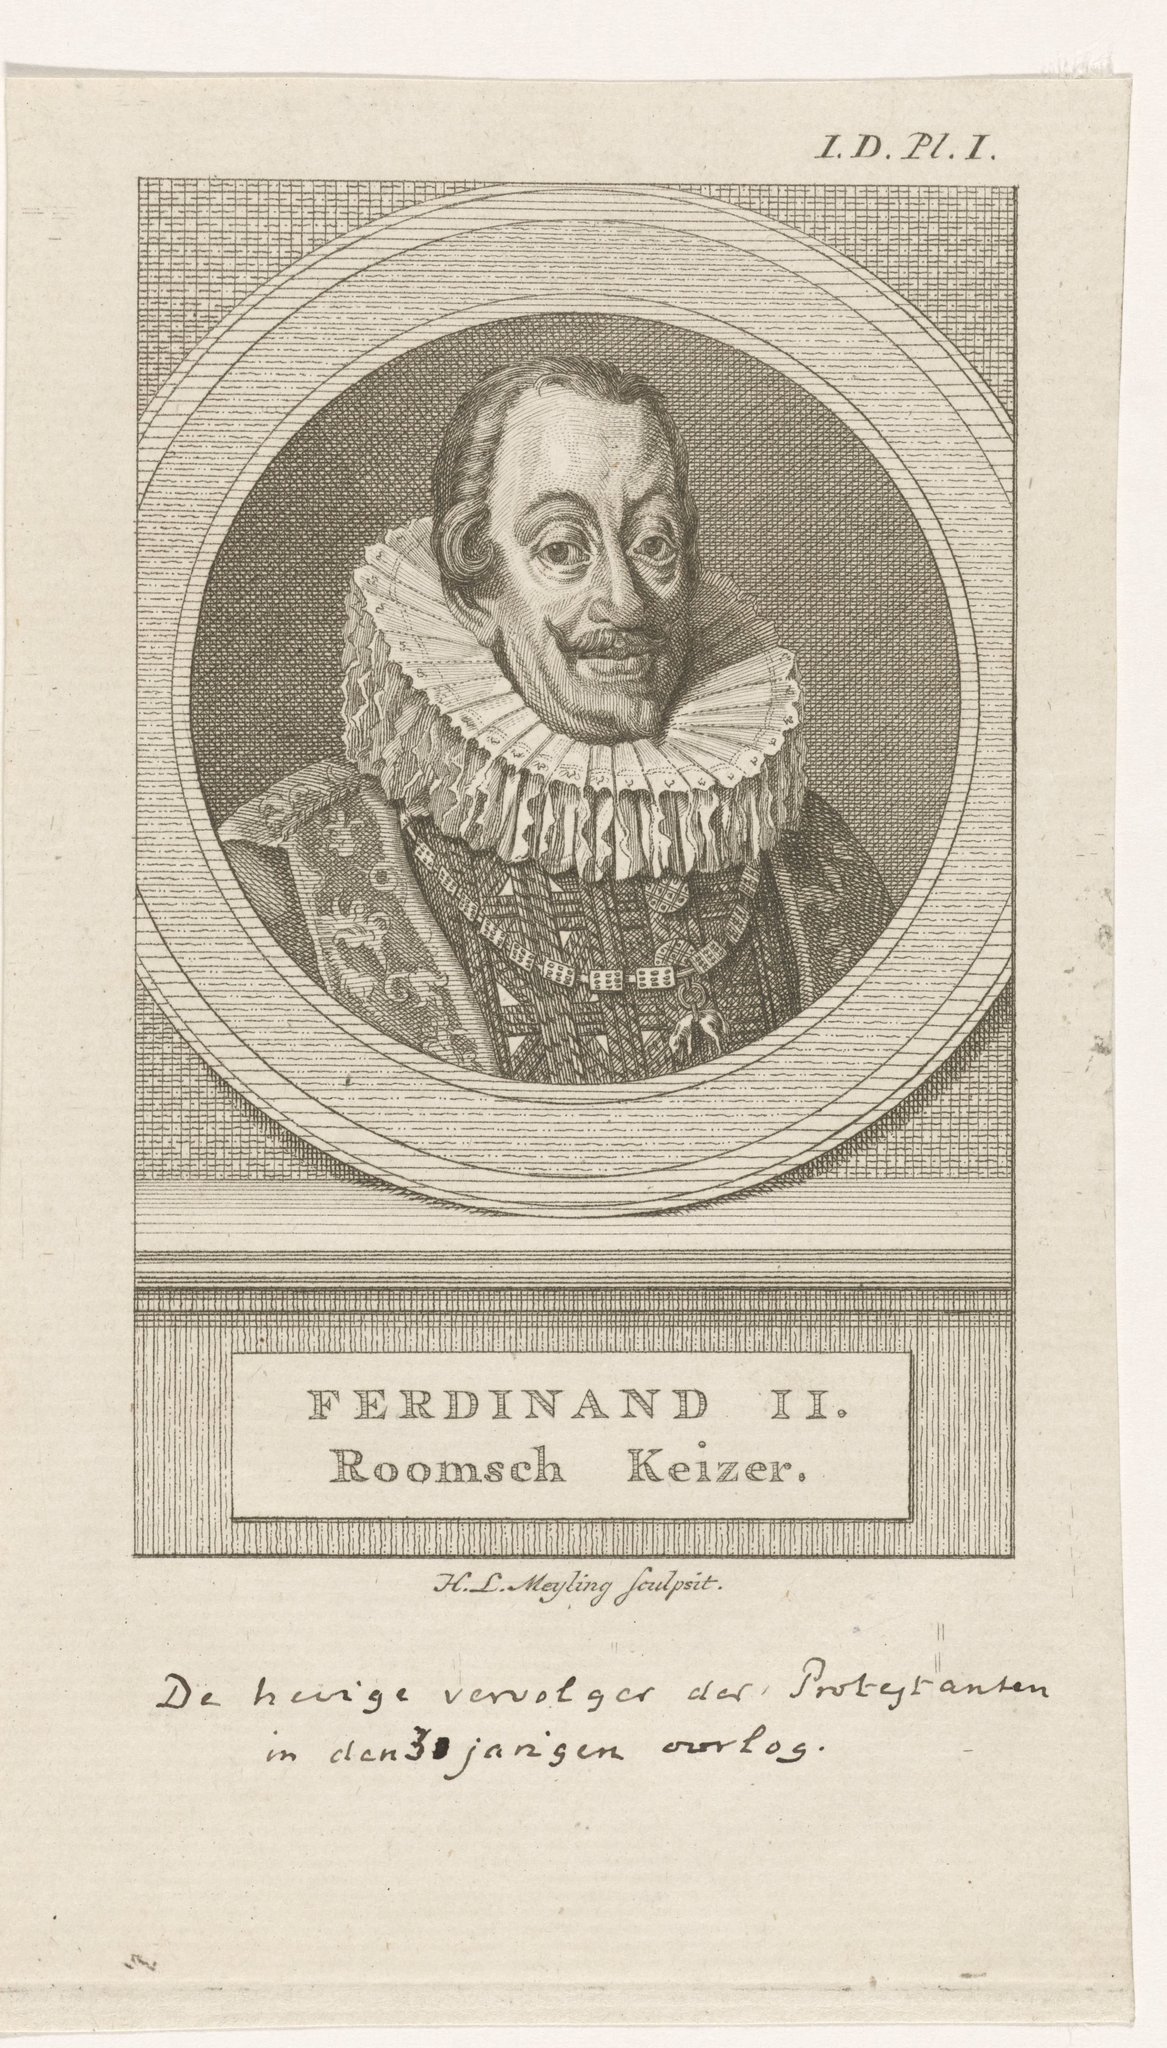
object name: print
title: Portret van Duits keizer Ferdinand II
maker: hendrik leffert meyling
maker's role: print maker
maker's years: 1757-1821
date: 1777-1821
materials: paper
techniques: etching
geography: netherlands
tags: vienna, ferdinand ii (duits keizer)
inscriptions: inscription: ‘De hevige vervolger der Protestanten in den 30 jarigen oorlog.’, collector's mark: Lugt 2228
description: Portret van Ferdinand II, Duits keizer, met een keten met de Orde van het Gulden Vlies op zijn borst. Rechtsboven genummerd: I.D. Pl. 1.